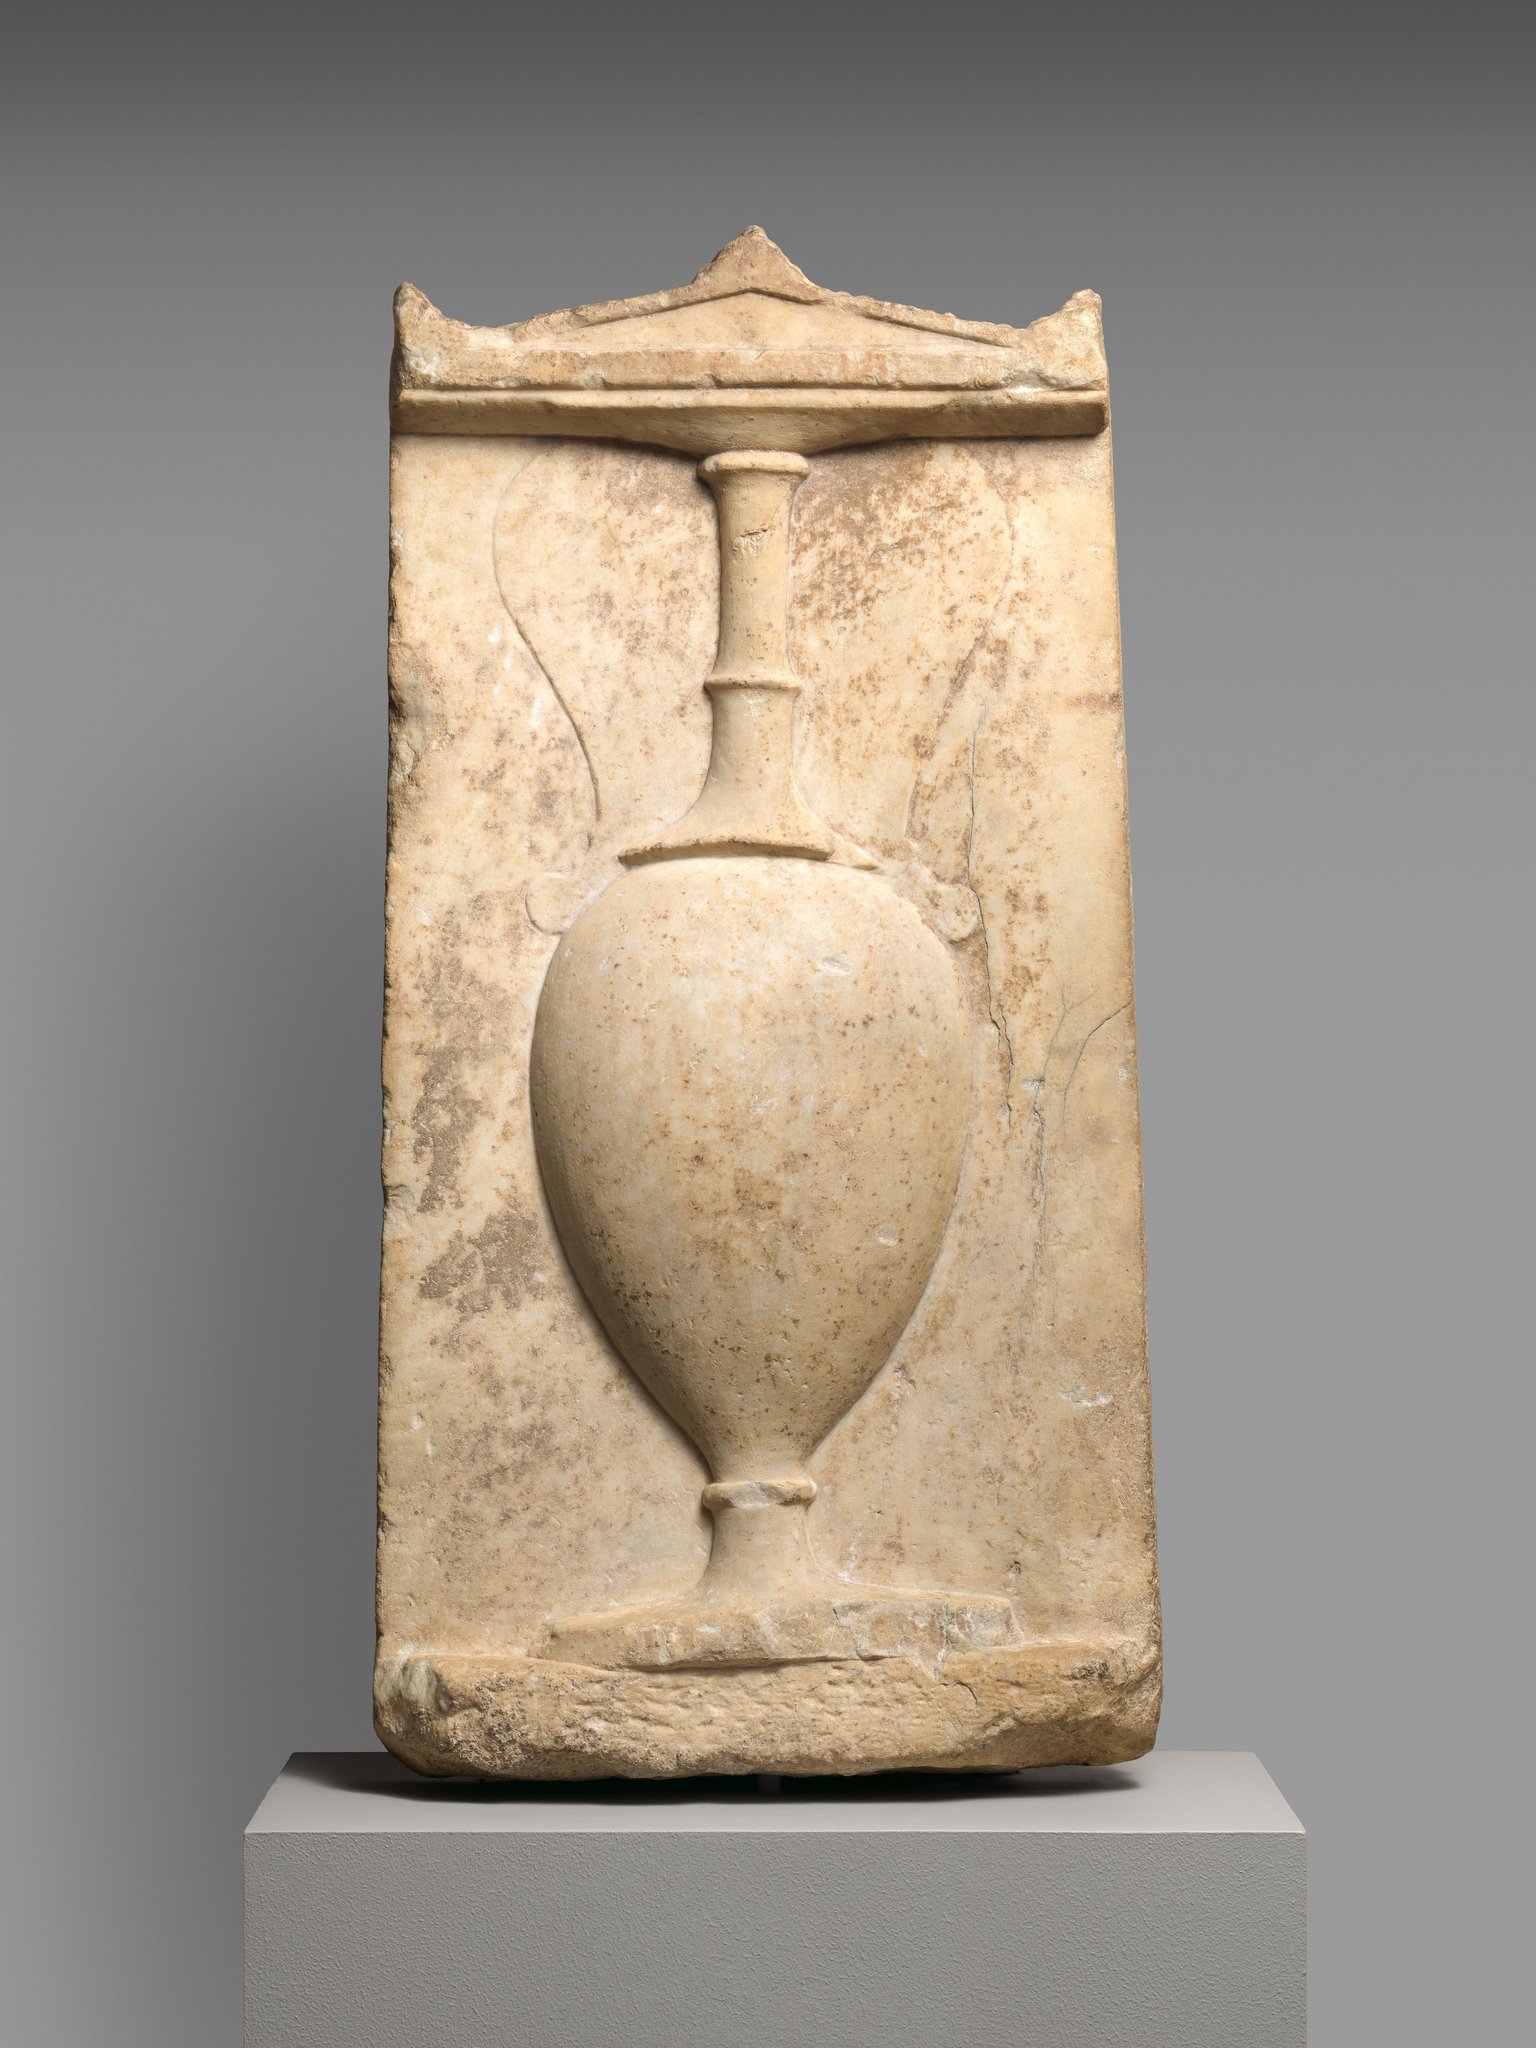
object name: grave stele of eukleia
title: Marble stele (grave marker) of Eukleia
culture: greek, attic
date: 400-301 BCE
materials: marble